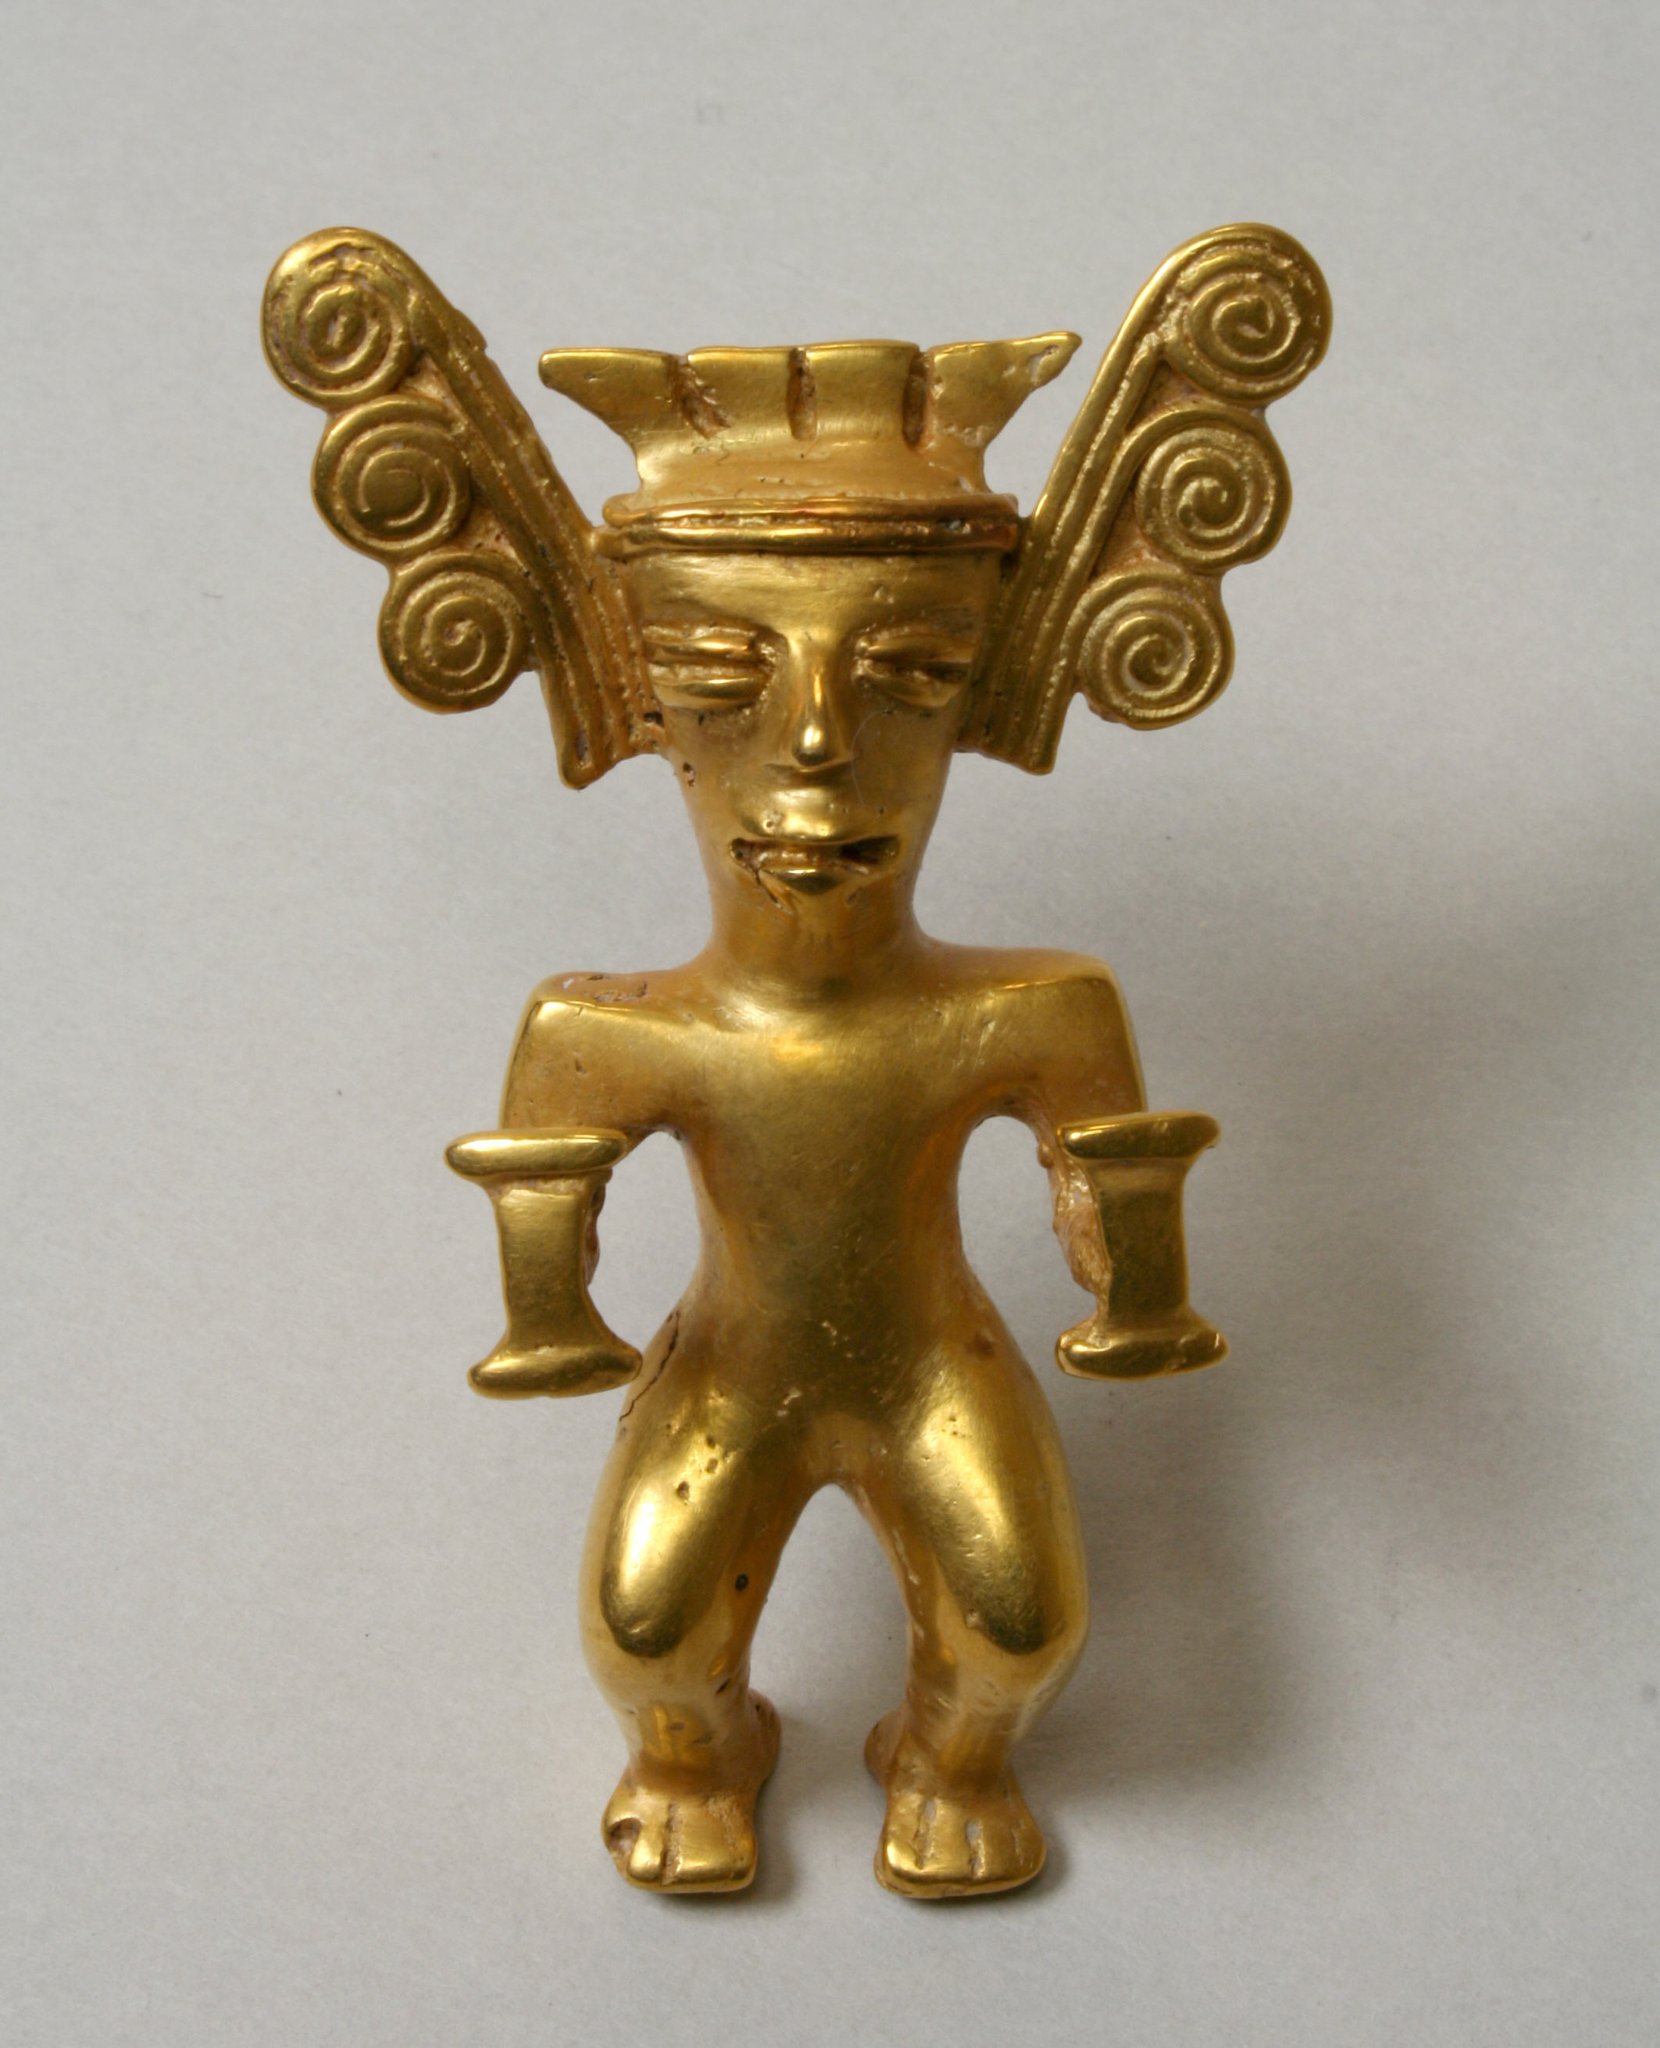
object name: pendant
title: Figure Pendant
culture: central caribbean or greater chiriquí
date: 501-1600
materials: alloy, gold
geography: costa rica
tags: men